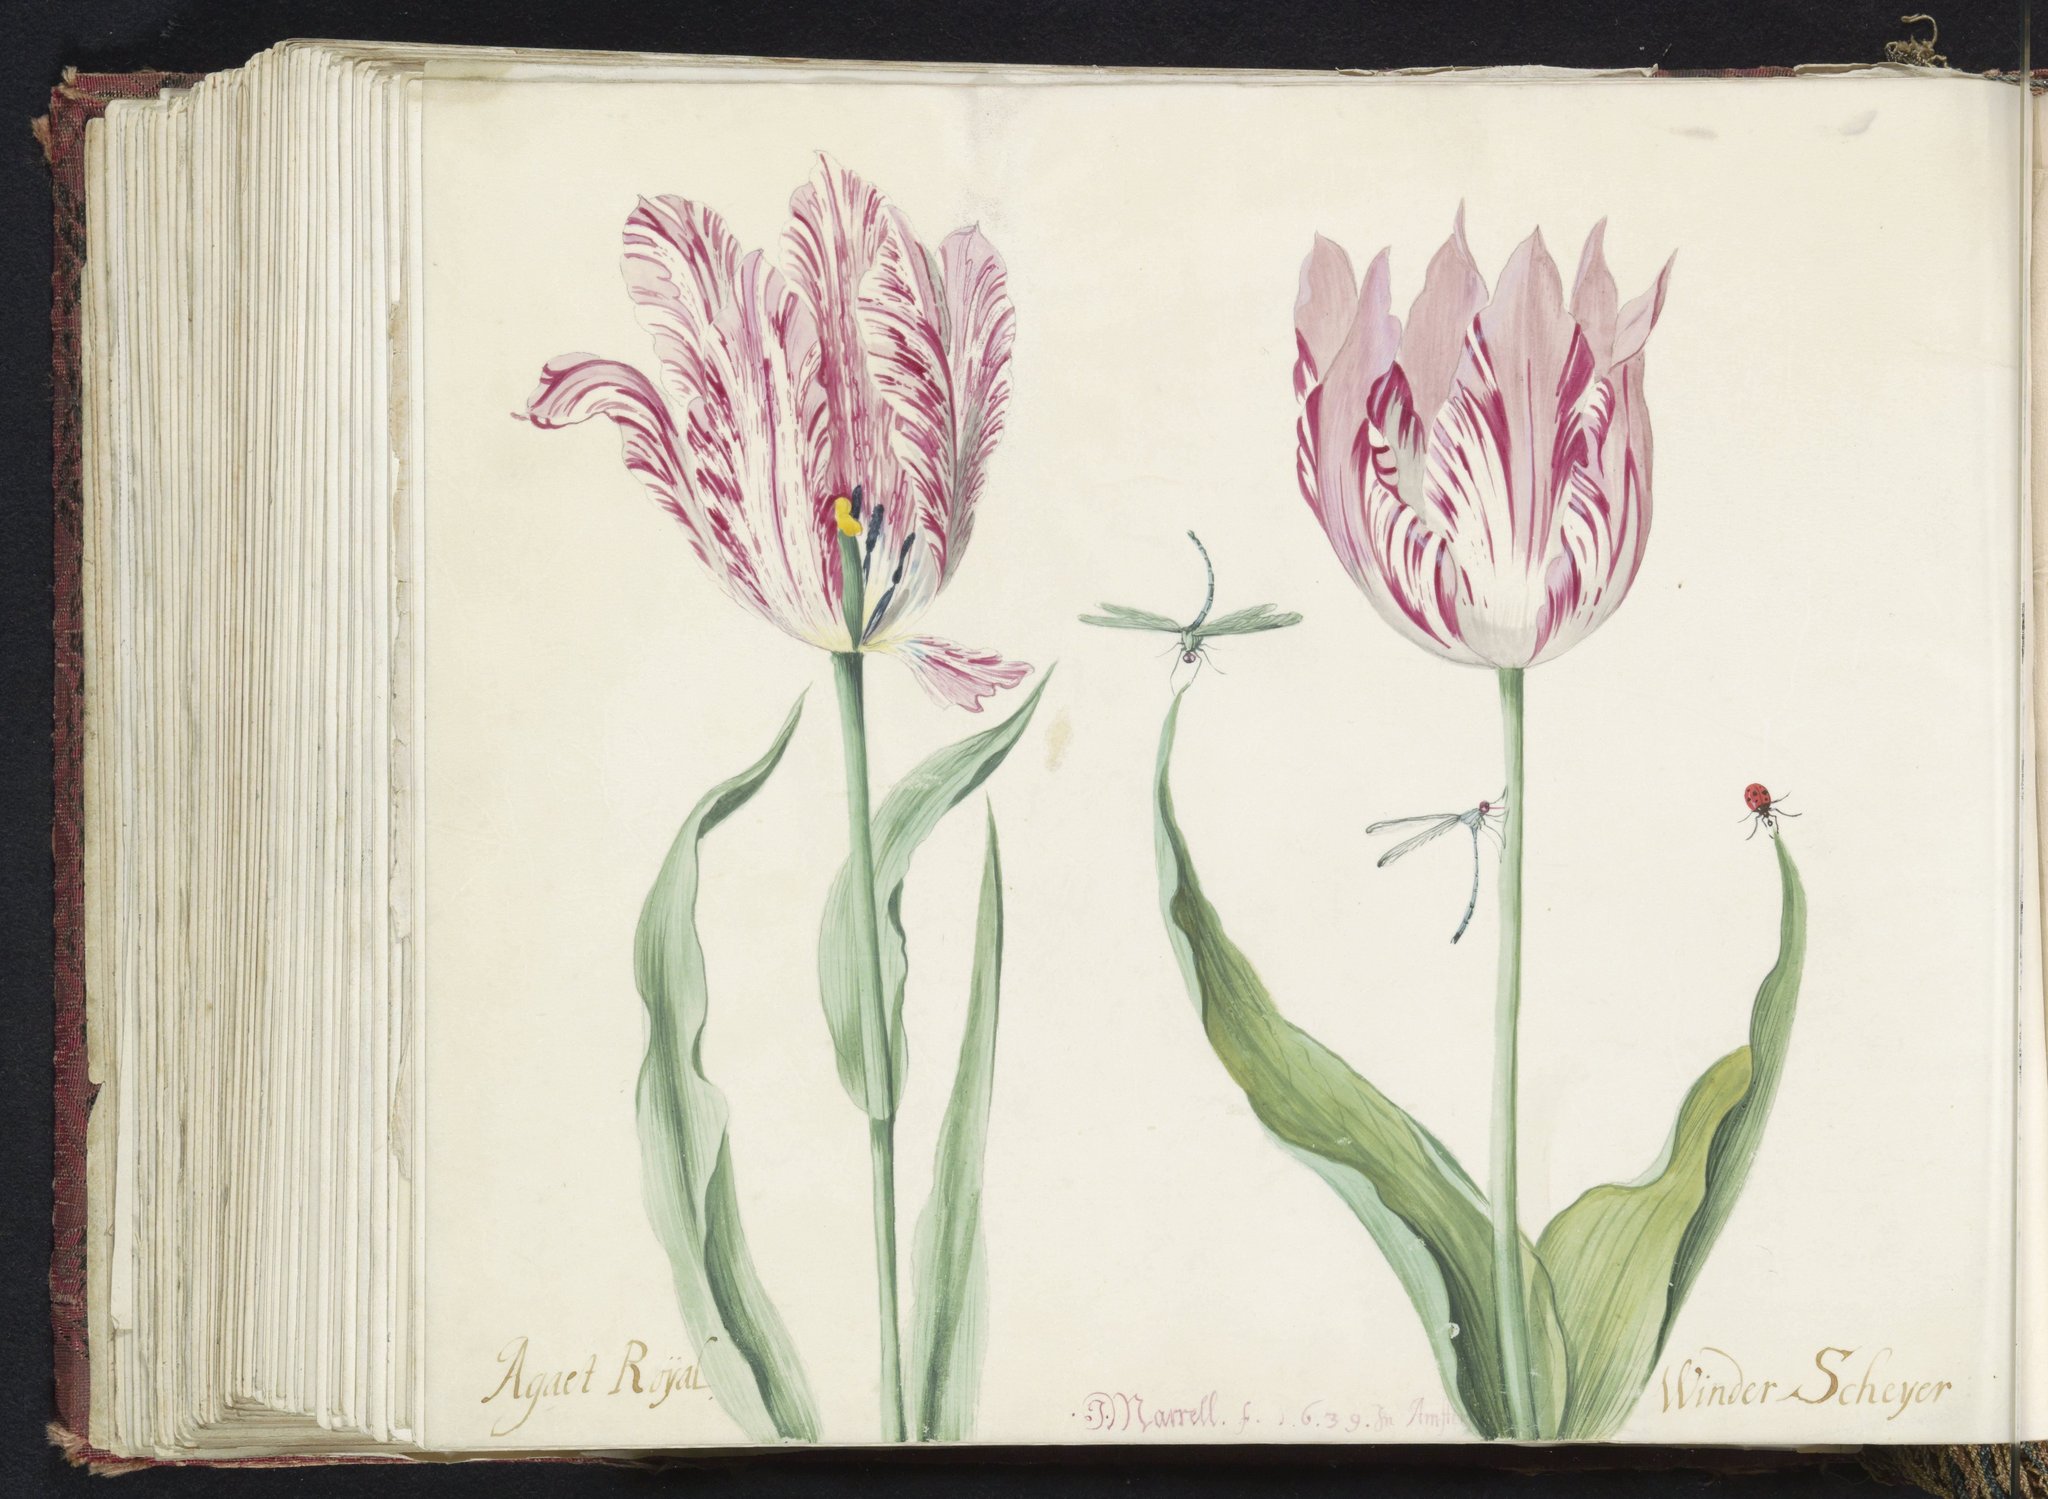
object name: album leaf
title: Agaet Roijal / Winder Scheyer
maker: jacob marrel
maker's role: draughtsman, painter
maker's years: 1614-1681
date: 1639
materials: paint, parchment, pencil, watercolor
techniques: brush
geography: amsterdam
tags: insects: dragon-fly, flowers: tulip, insects: beetle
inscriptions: date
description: De tekening maakt deel uit van een album.